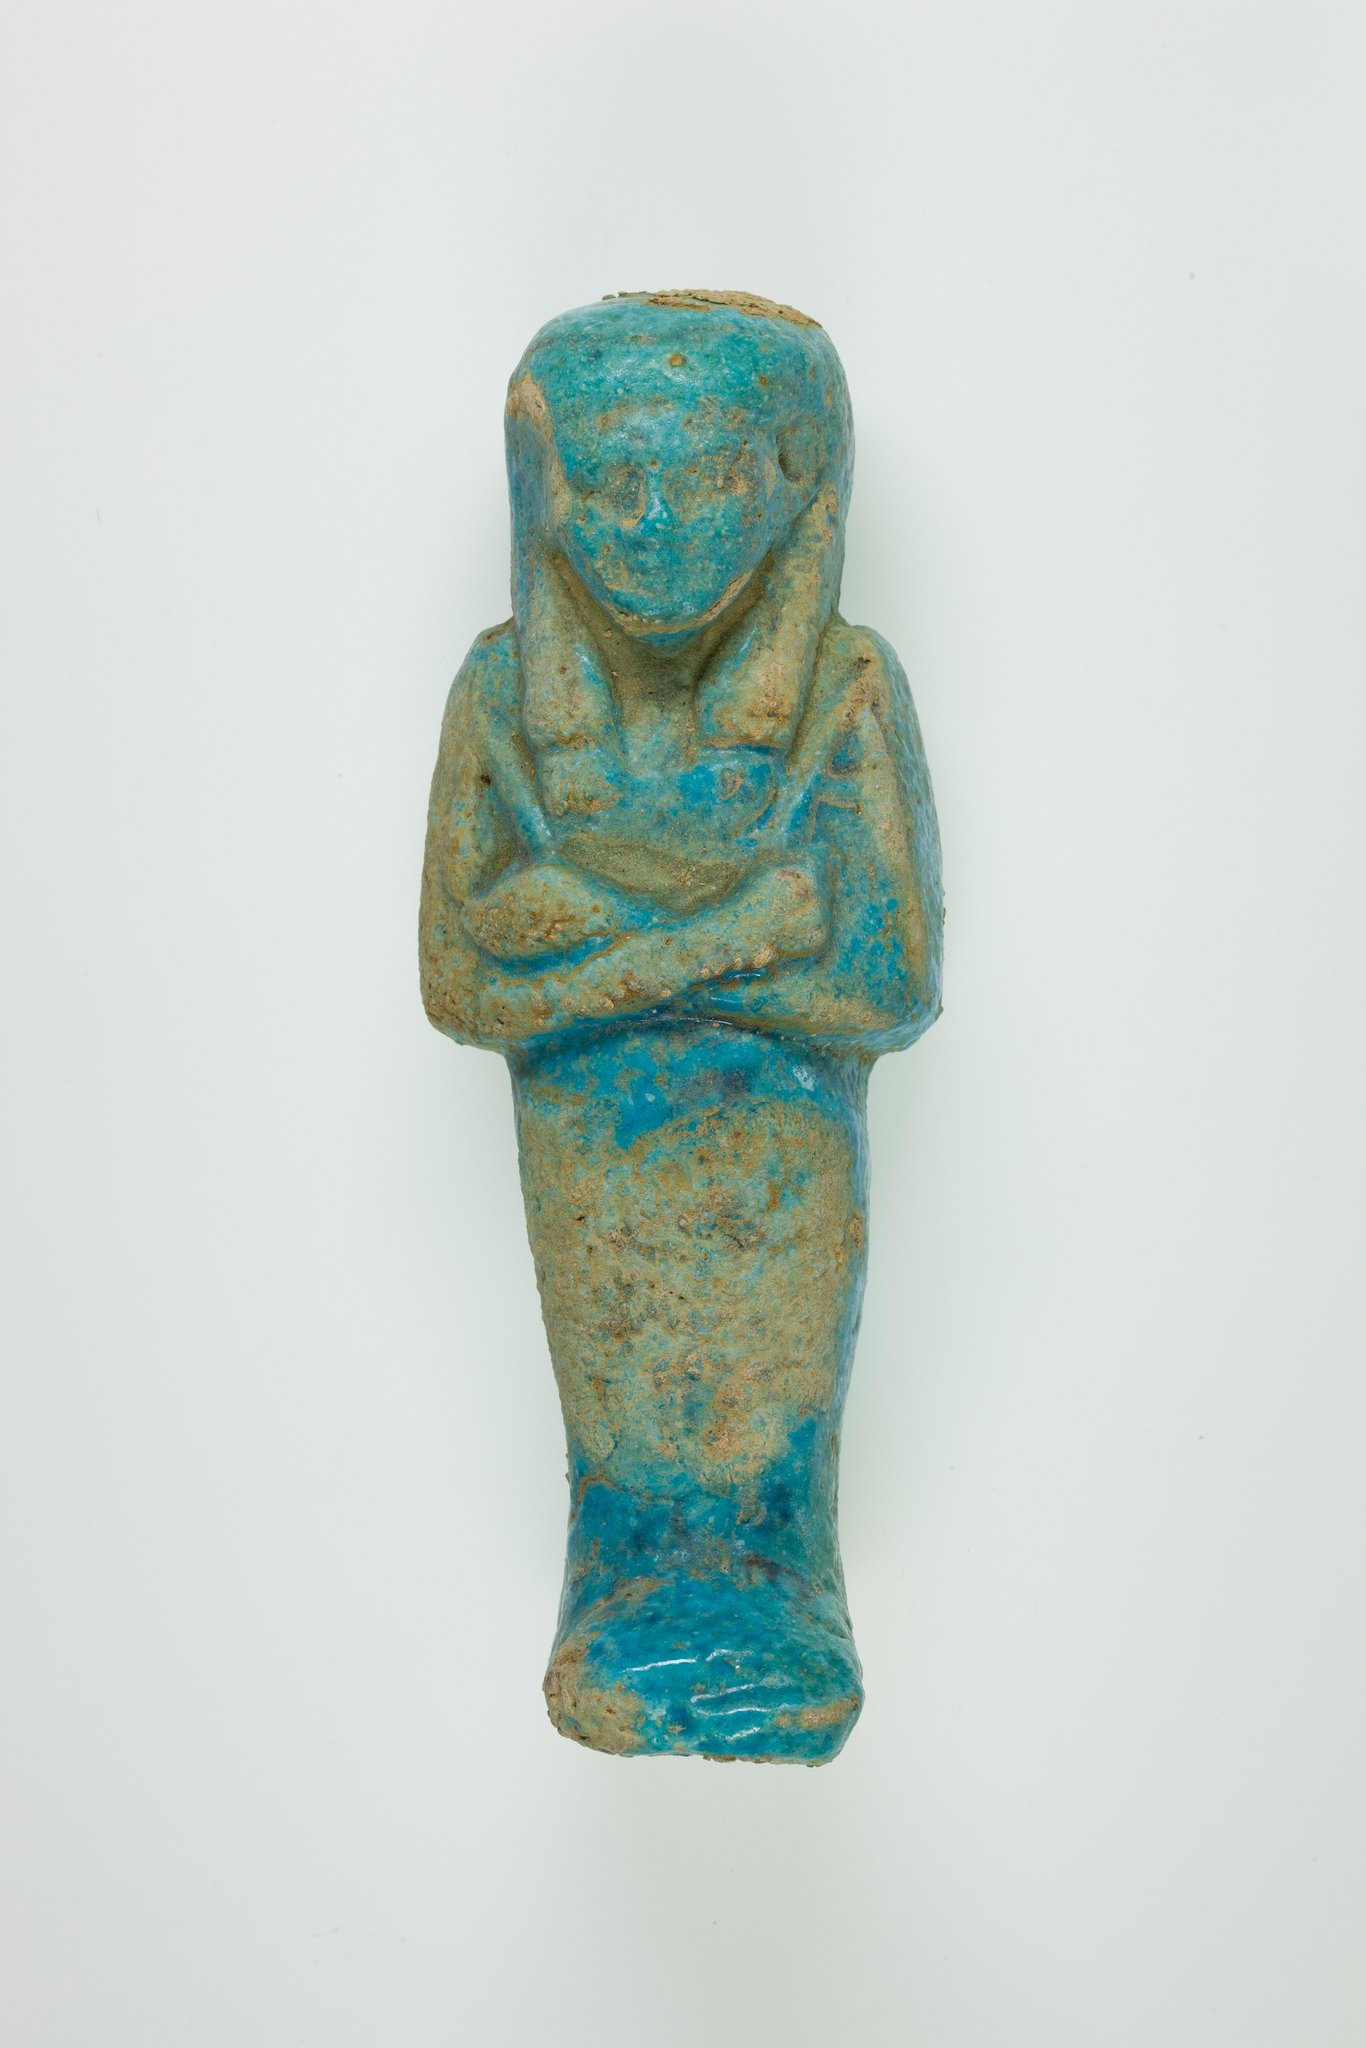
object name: worker shabti, henettawy c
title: Worker Shabti of Henettawy (C), Daughter of Isetemkheb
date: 990-970 BCE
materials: faience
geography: egypt